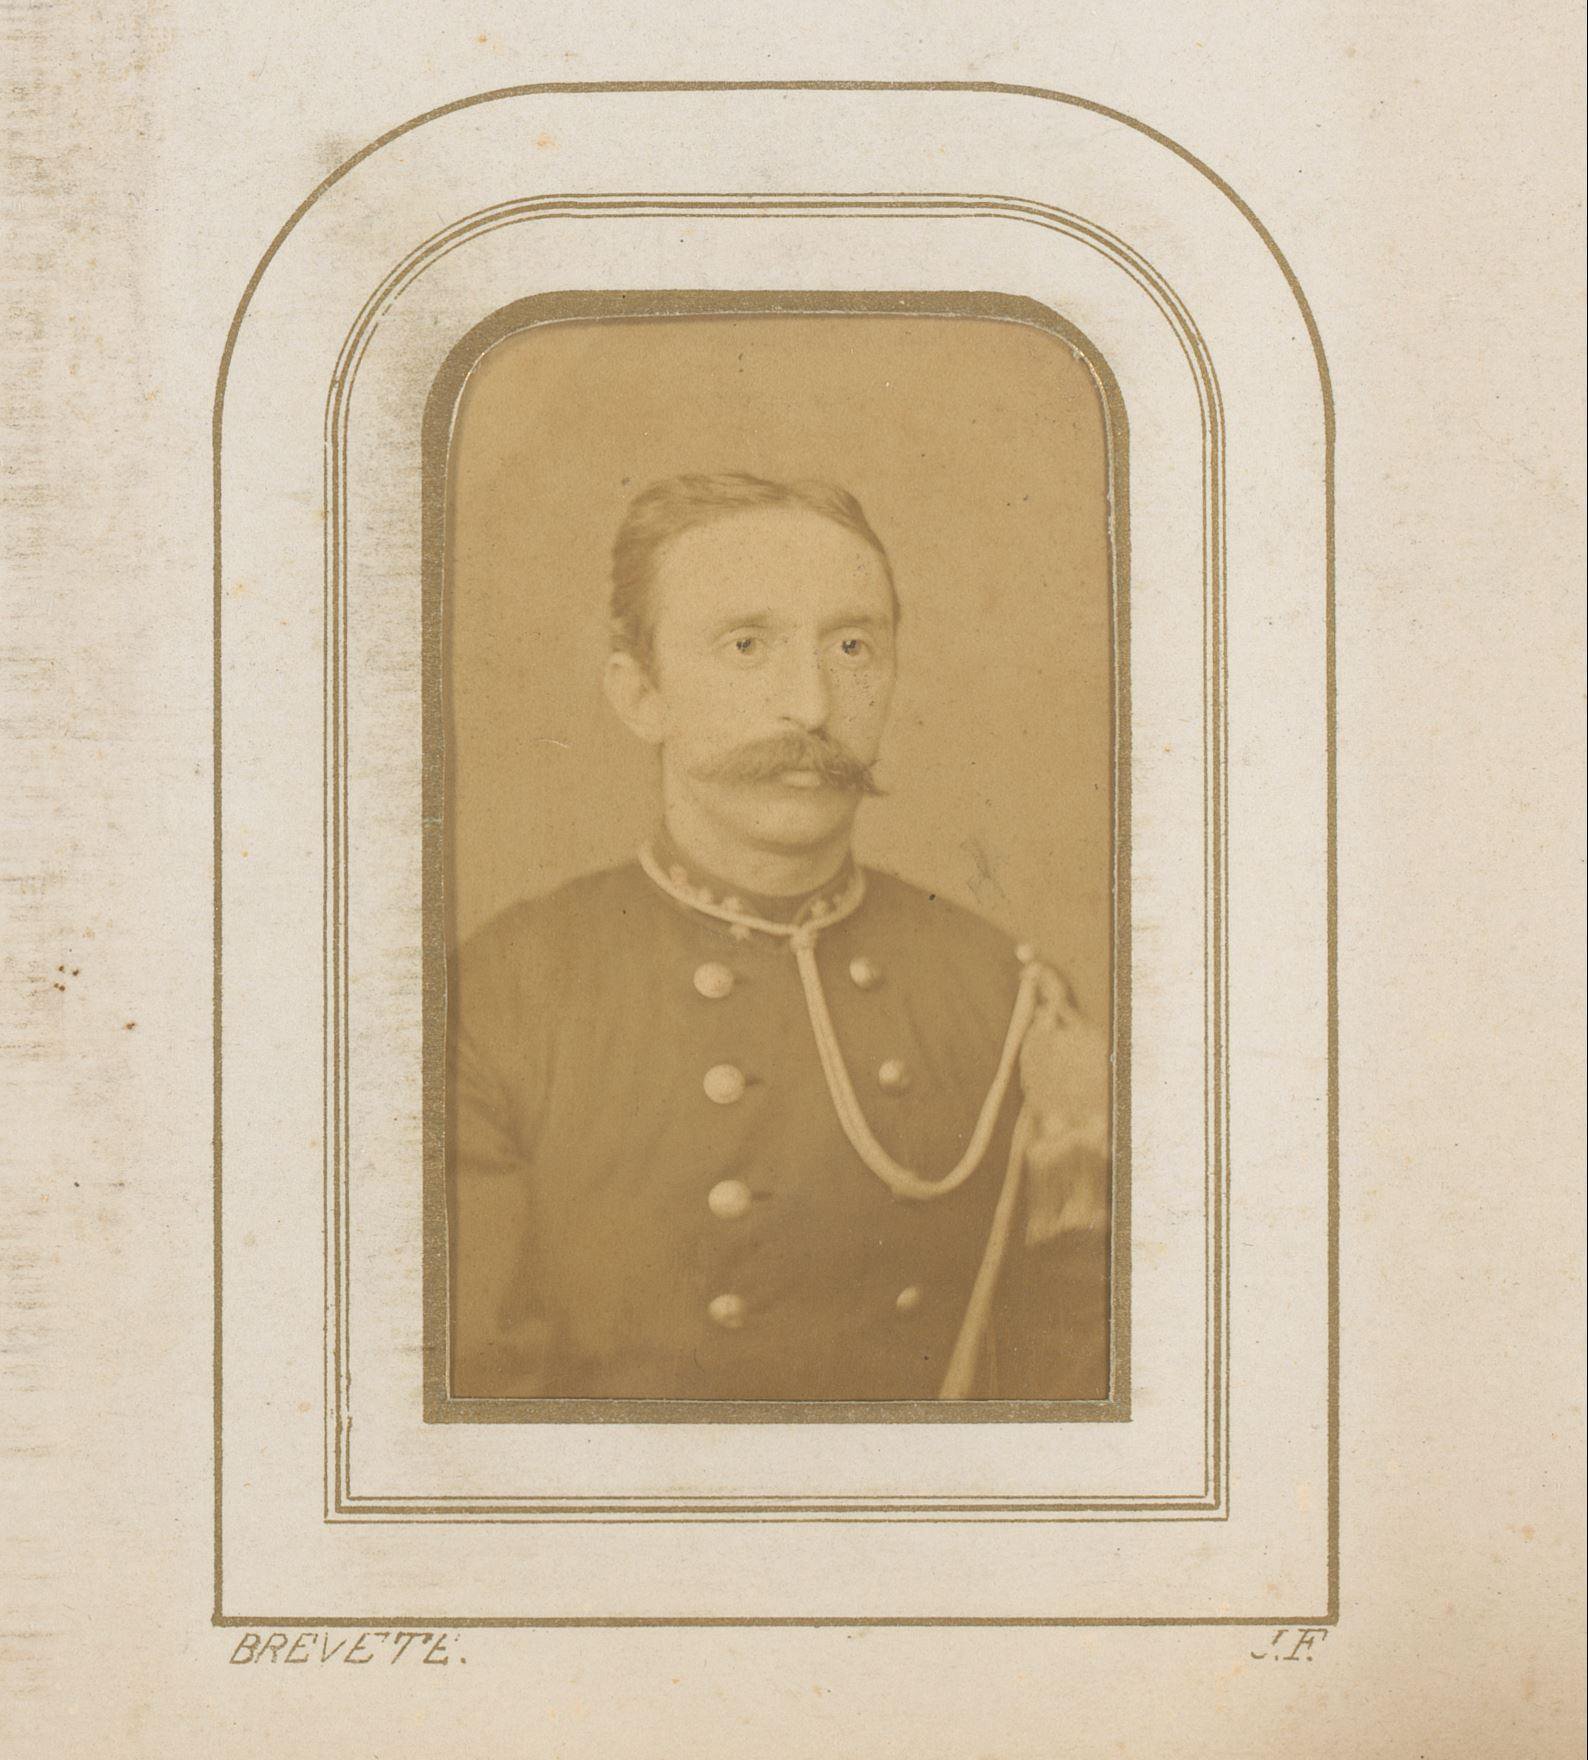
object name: photograph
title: Portret van een man met snor in uniform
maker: charles de trez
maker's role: painter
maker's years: 1822-1899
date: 1860-1882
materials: cardboard, photographic support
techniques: albumen print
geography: brussels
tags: moustache, historical persons, (military) uniforms